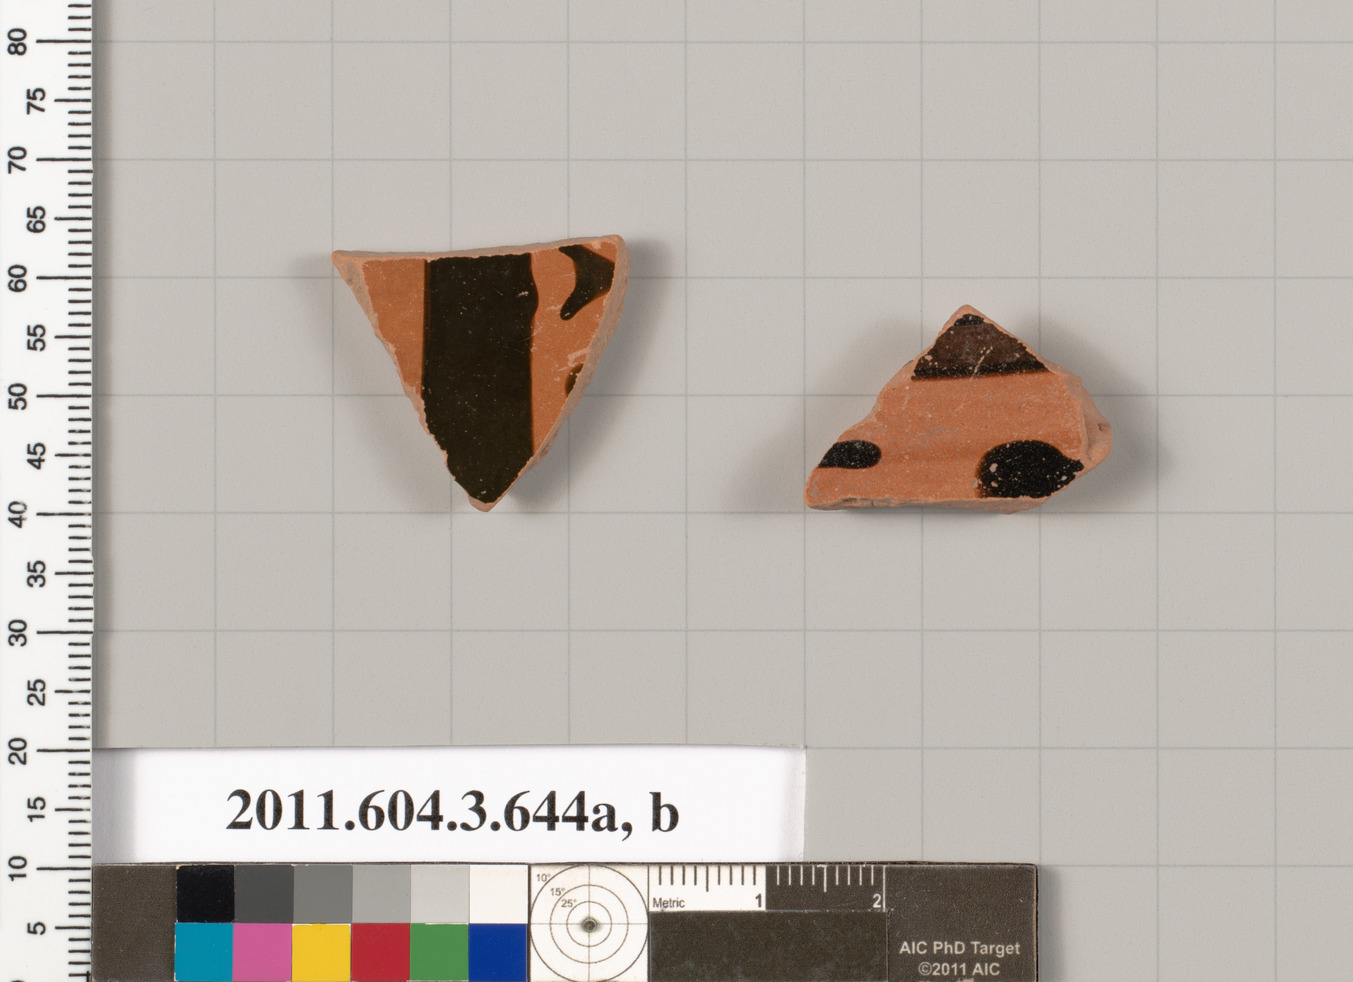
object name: column krater fragment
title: Terracotta fragments of column-kraters (bowls for mixing wine and water)?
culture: greek, attic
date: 534-468 BCE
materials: terracotta